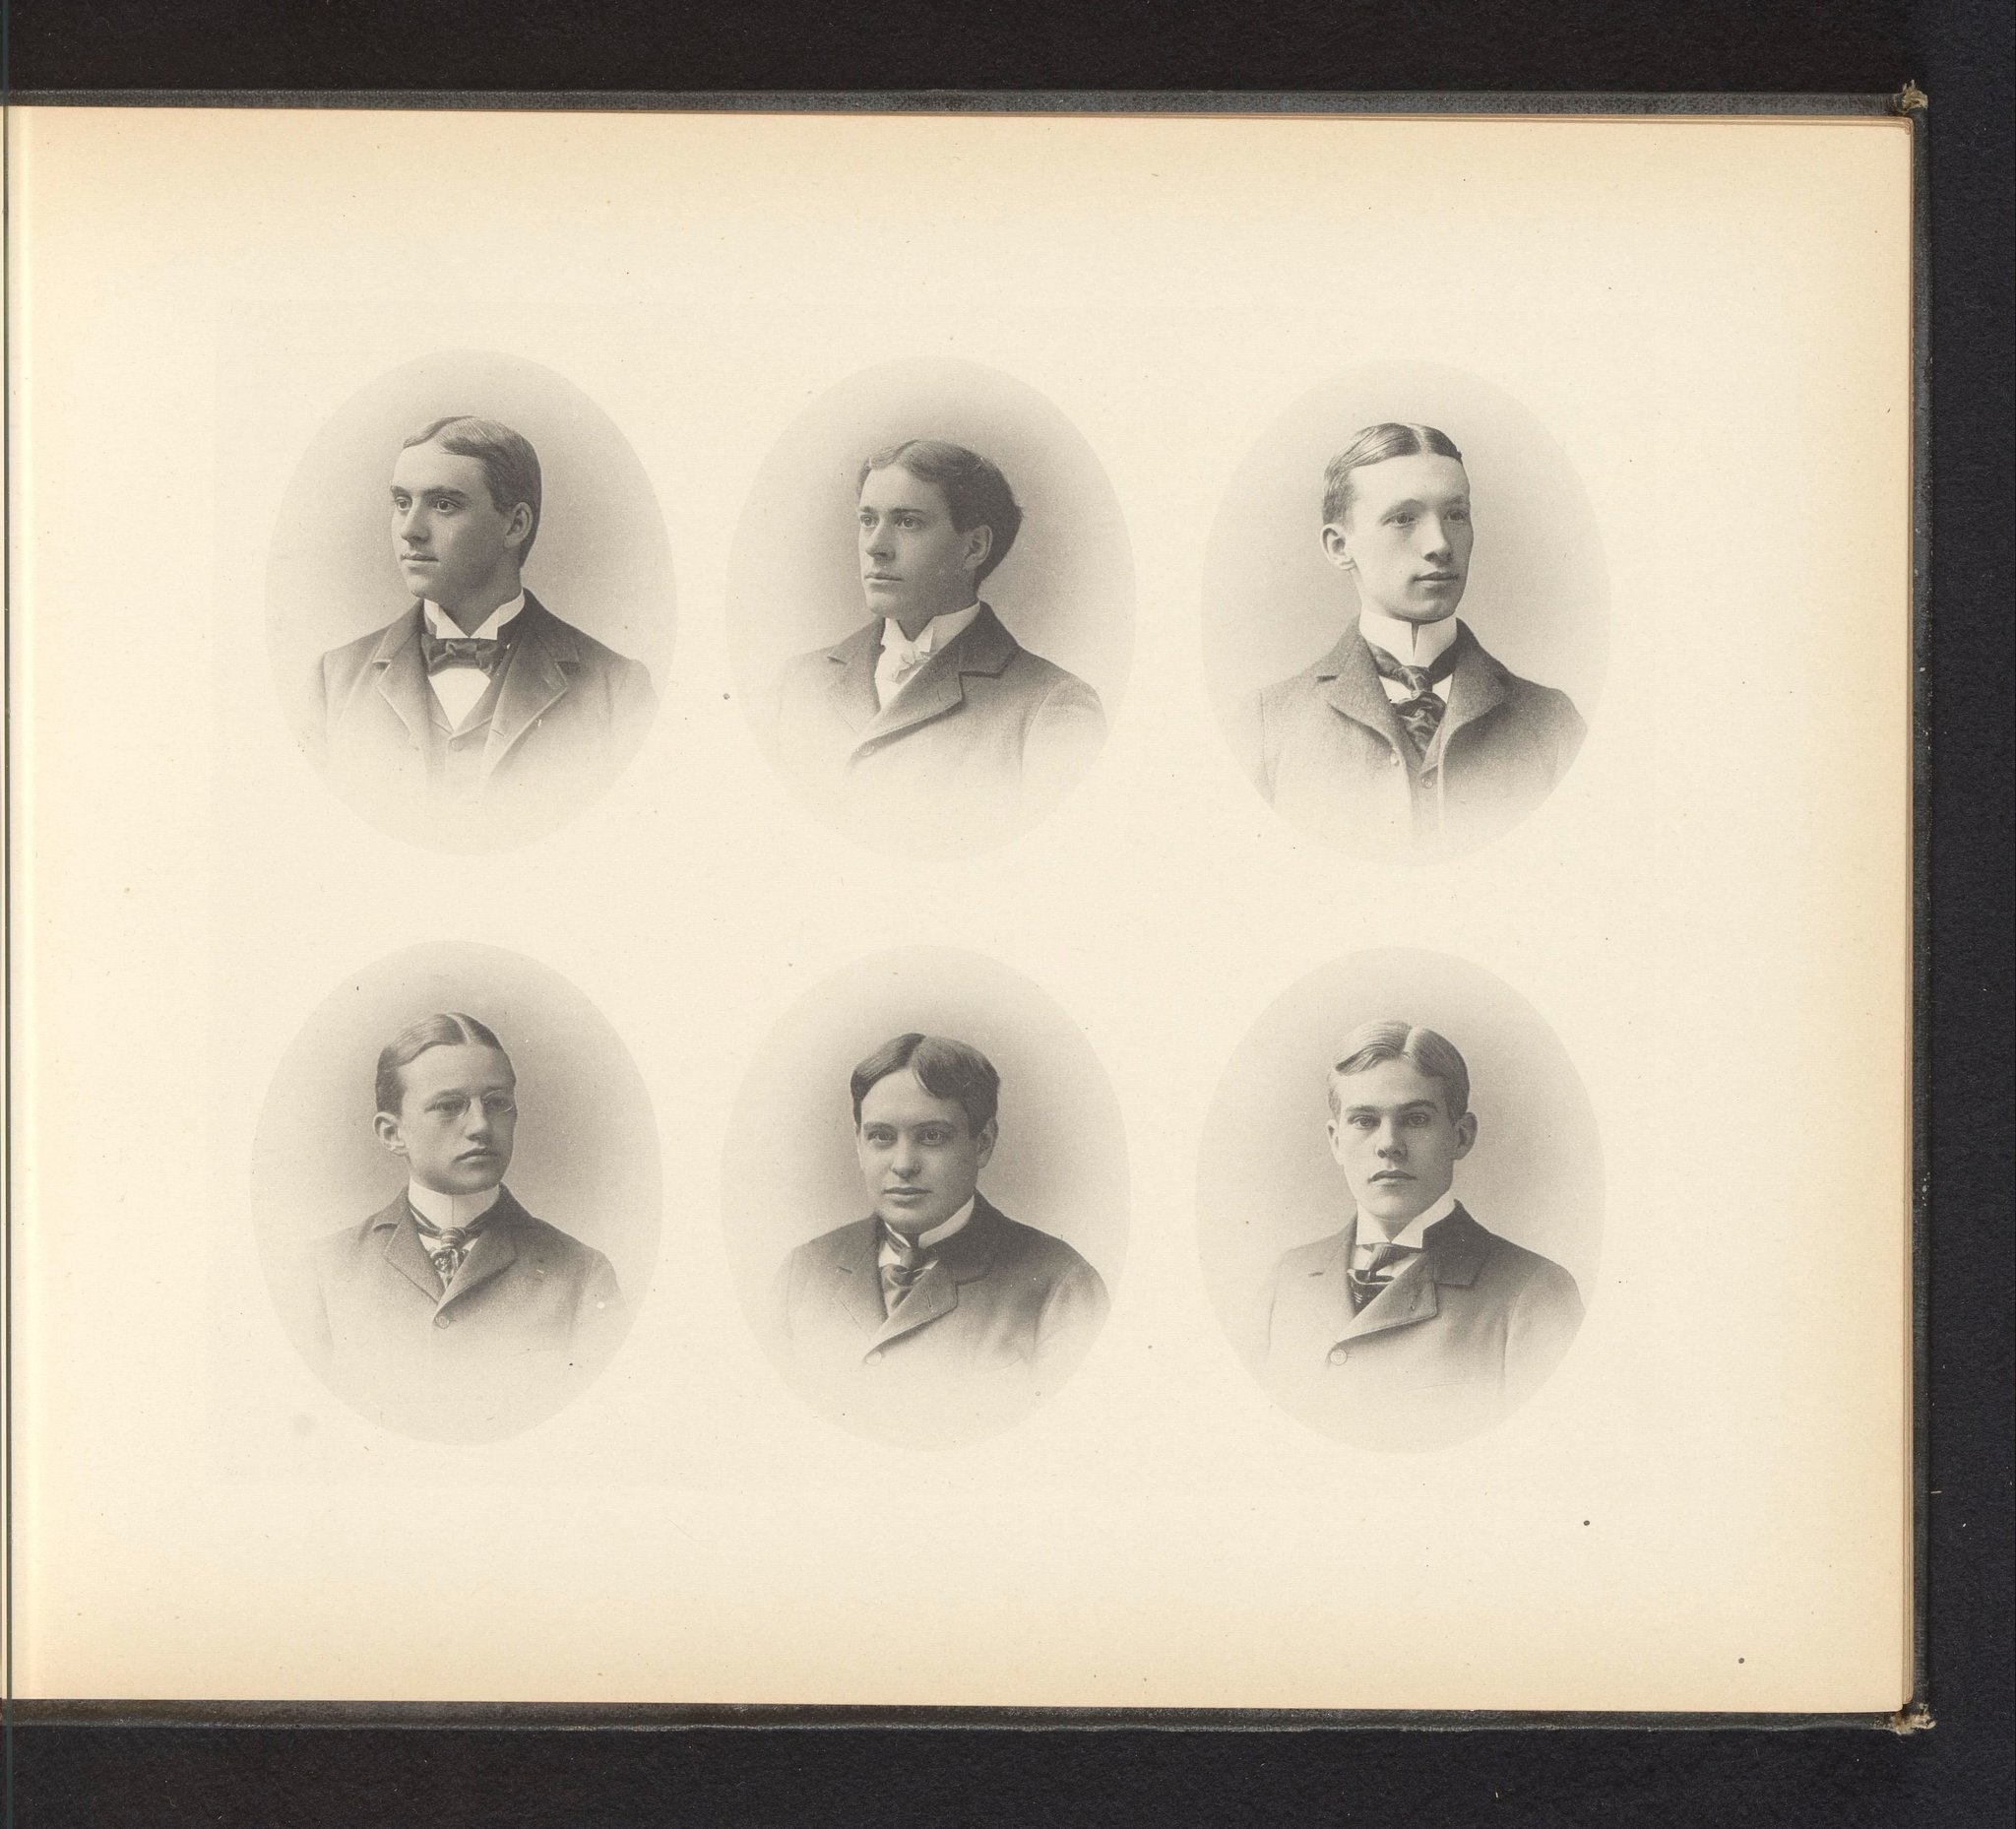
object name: page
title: Zes portretten van afgestudeerde studenten van Yale University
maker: Anonymous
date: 1895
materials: paper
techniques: photograph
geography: new york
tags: student